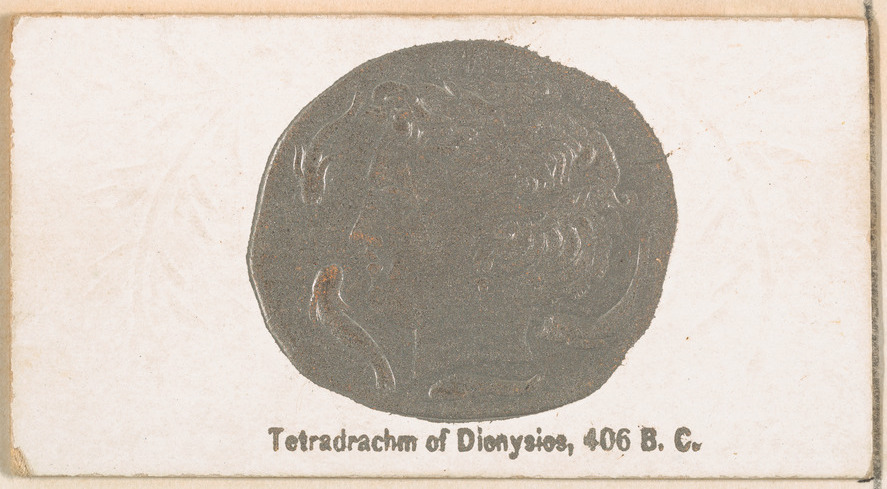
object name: print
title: Tetradrachm of Dionysios, 406 B.C., from the Ancient Coins series (N180) issued by Wm. S. Kimball & Co.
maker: william s. kimball & company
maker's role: publisher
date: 1888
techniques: color lithograph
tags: coins